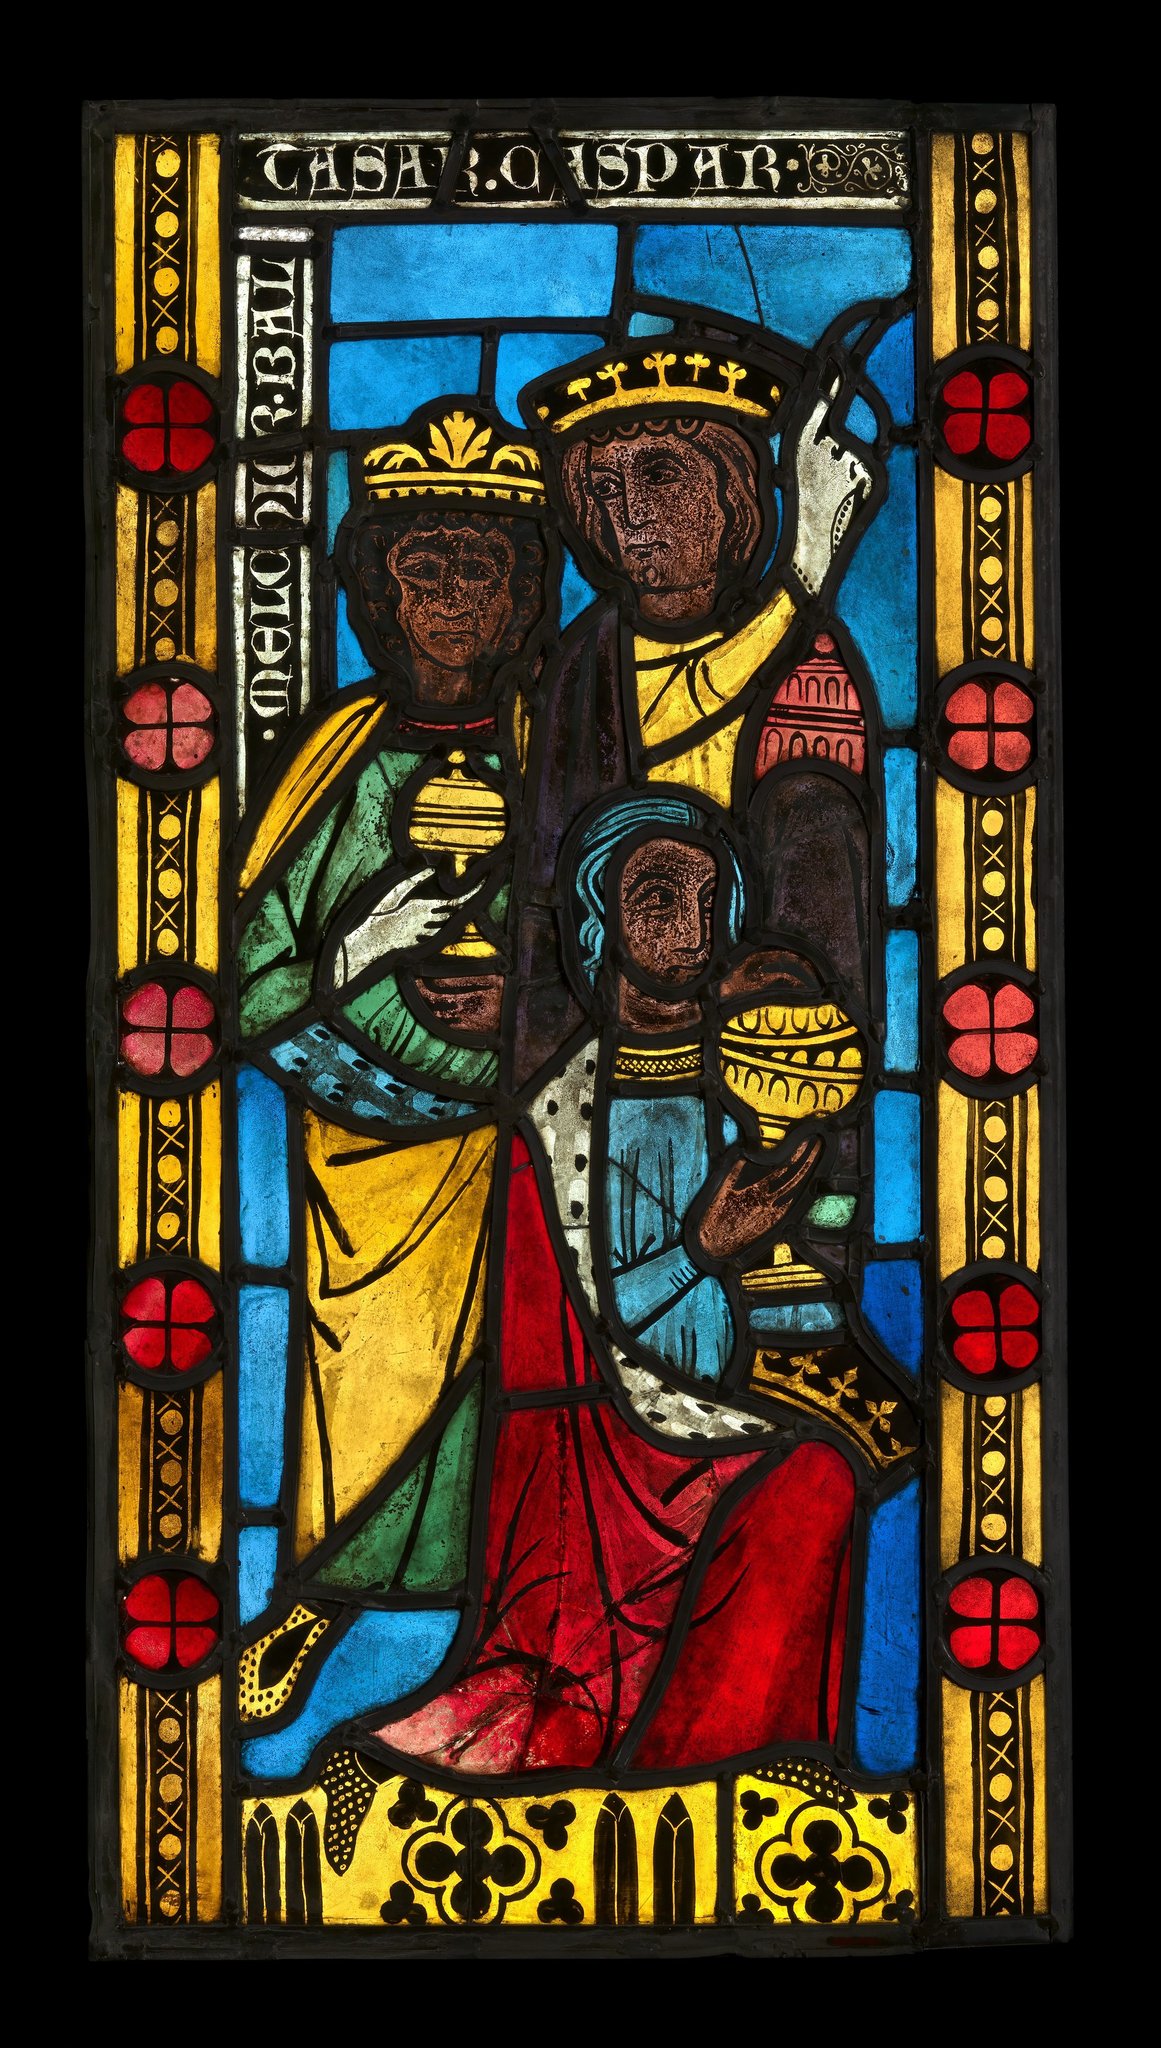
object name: stained glass panel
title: The Adoration of the Magi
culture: german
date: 1290-1300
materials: glass, metal, paint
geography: germany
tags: christ,madonna and child,virgin mary,adoration of the magi